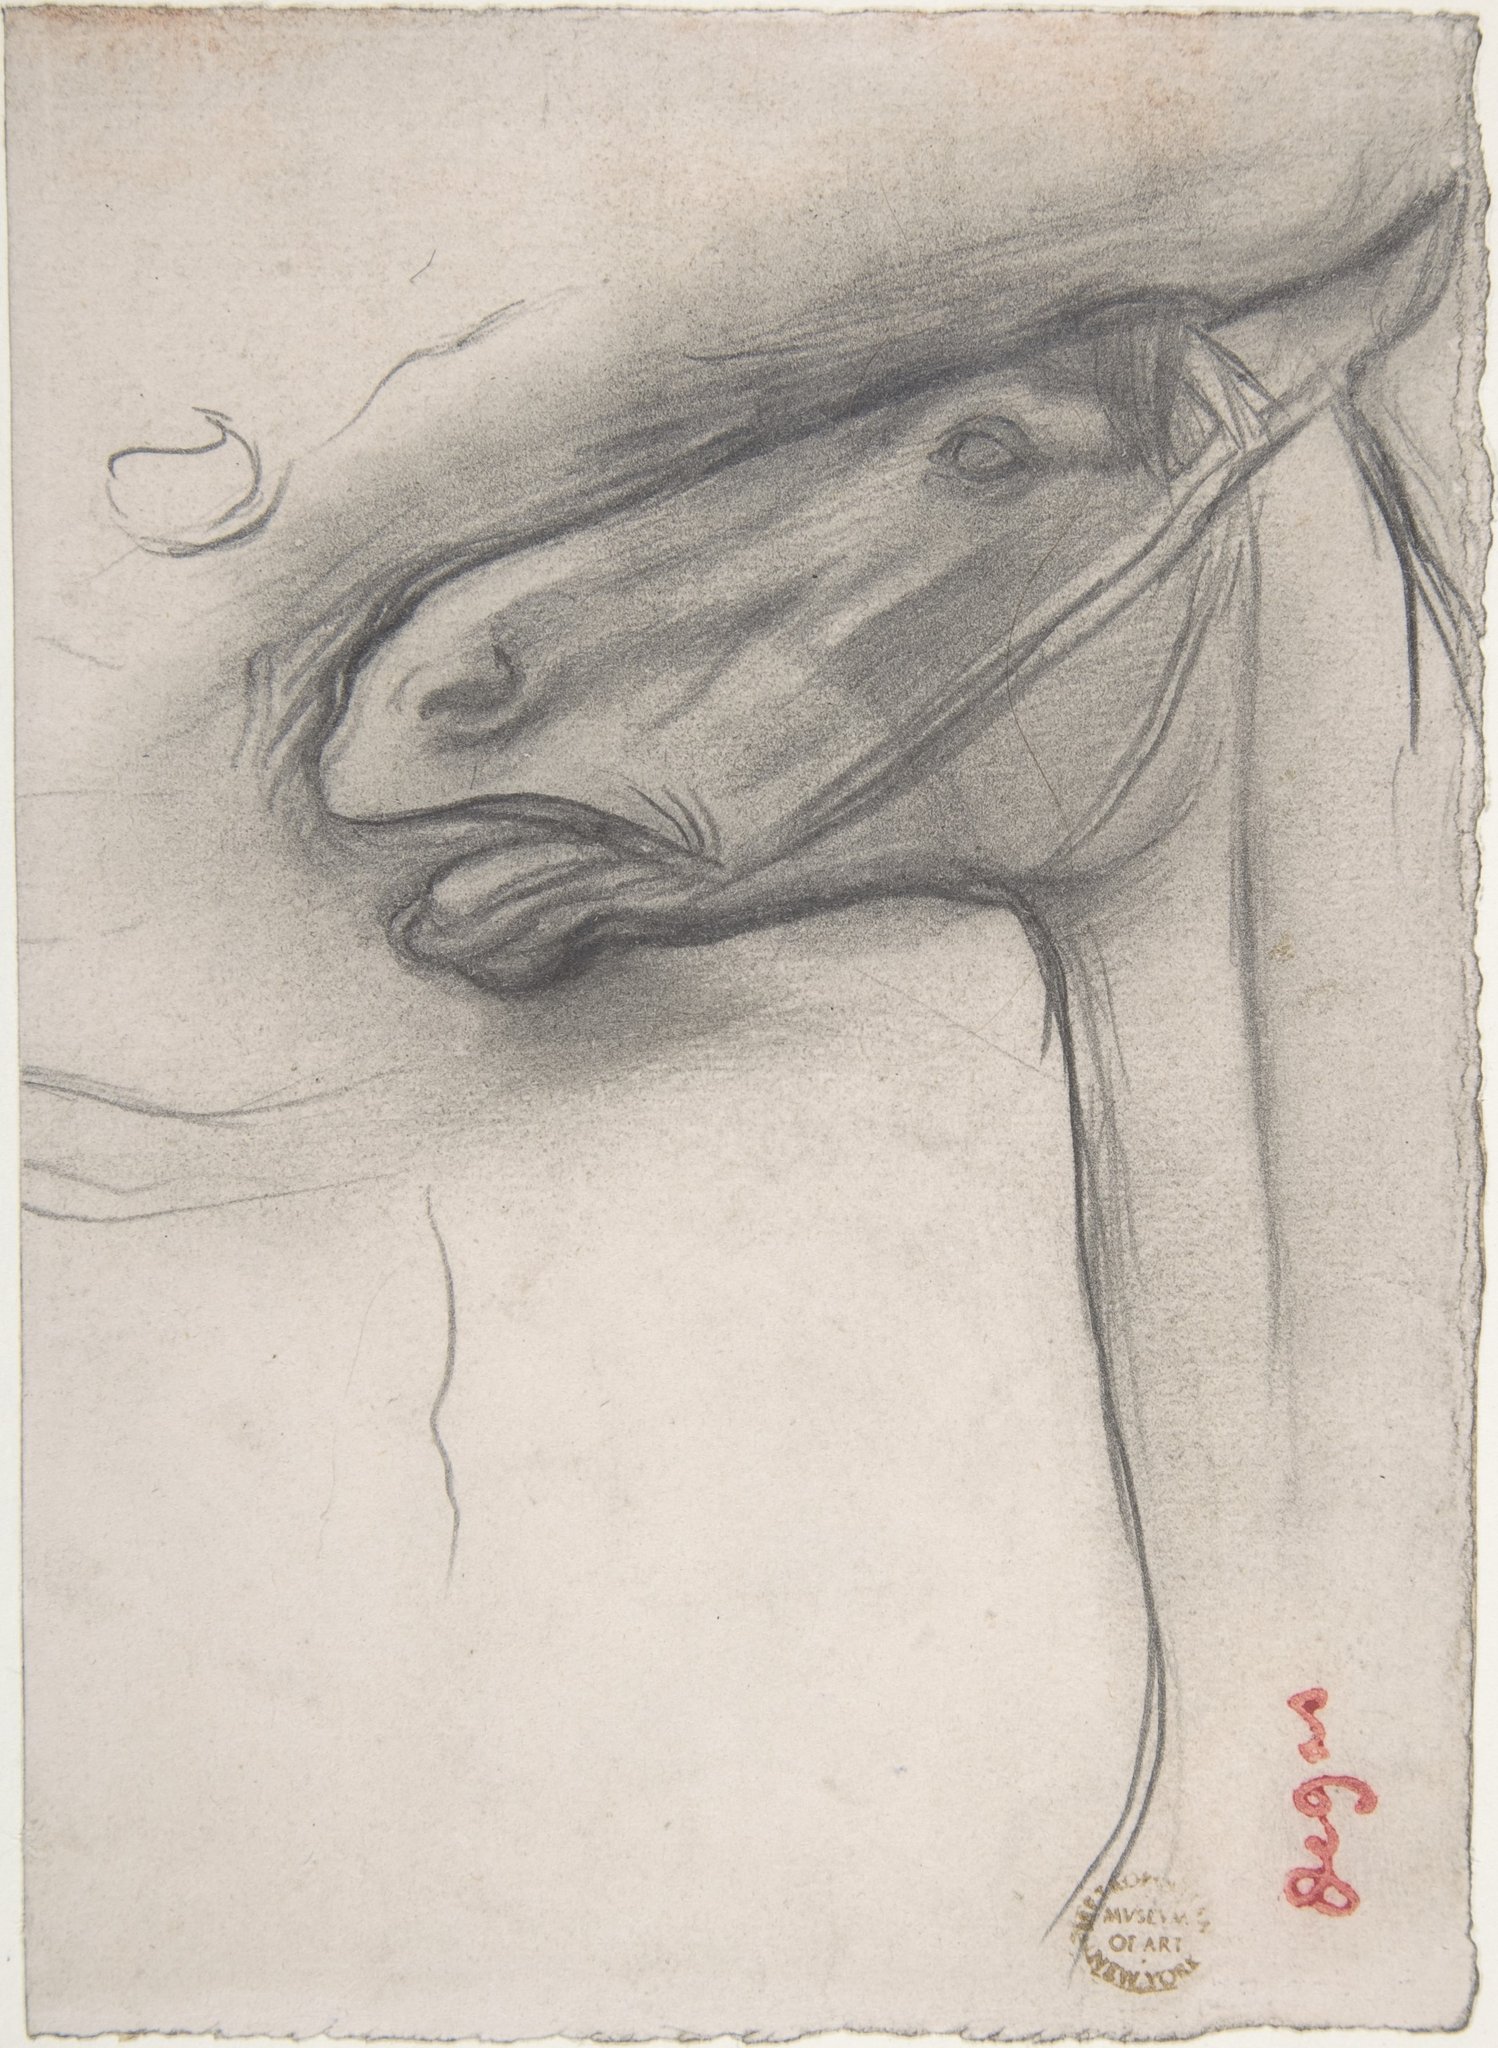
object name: drawing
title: Head of a Horse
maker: edgar degas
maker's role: artist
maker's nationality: french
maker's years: 1834-1917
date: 1878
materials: graphite, paper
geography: france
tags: horses